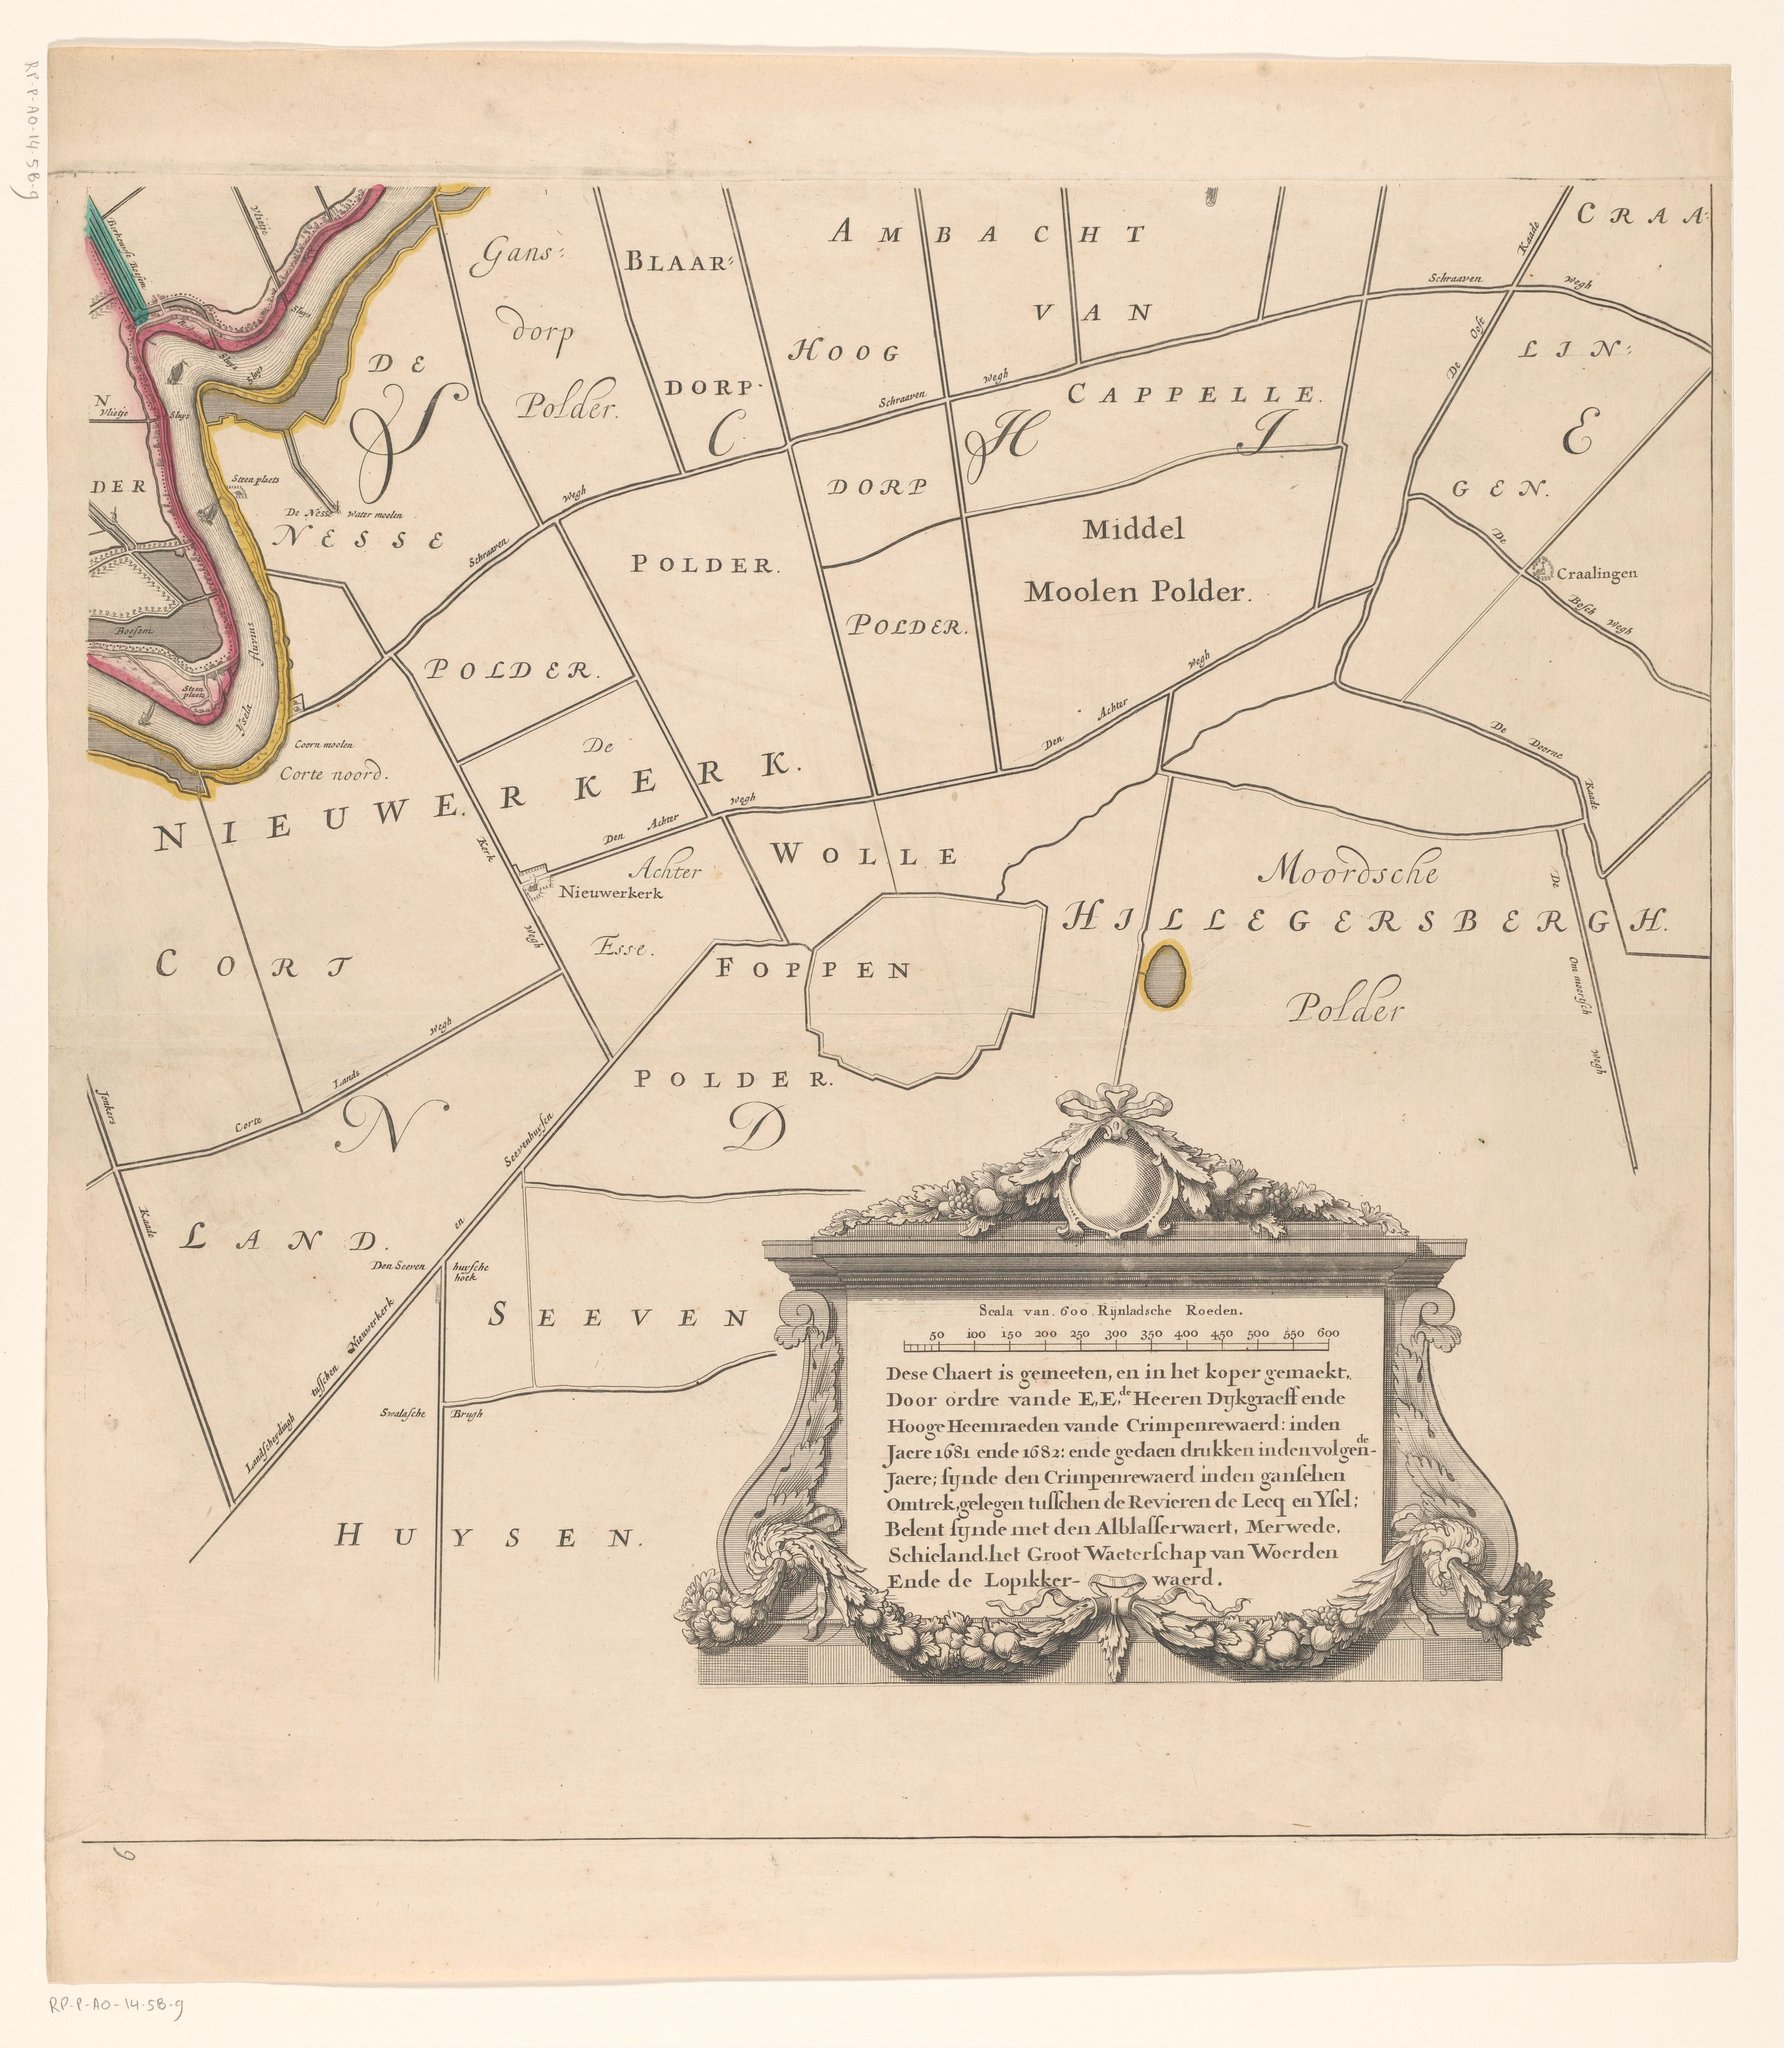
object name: print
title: Kaart van het Hoogheemraadschap van de Krimpenerwaard (zesde deel van kaart)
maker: johannes leupenius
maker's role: draughtsman, painter, print maker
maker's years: 1646-1693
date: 1683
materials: paper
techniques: engraving, etching, hand coloring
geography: amsterdam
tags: maps of separate countries or regions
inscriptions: date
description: Zesde deel van de kaart van de eerste druk van 'Het Hooge Heemraadschap vande Crimpenre Waard', een wandkaart (bestaande uit een zesdelige kaart en een wapenrand) van het Hoogheemraadschap van de Krimpenerwaard.